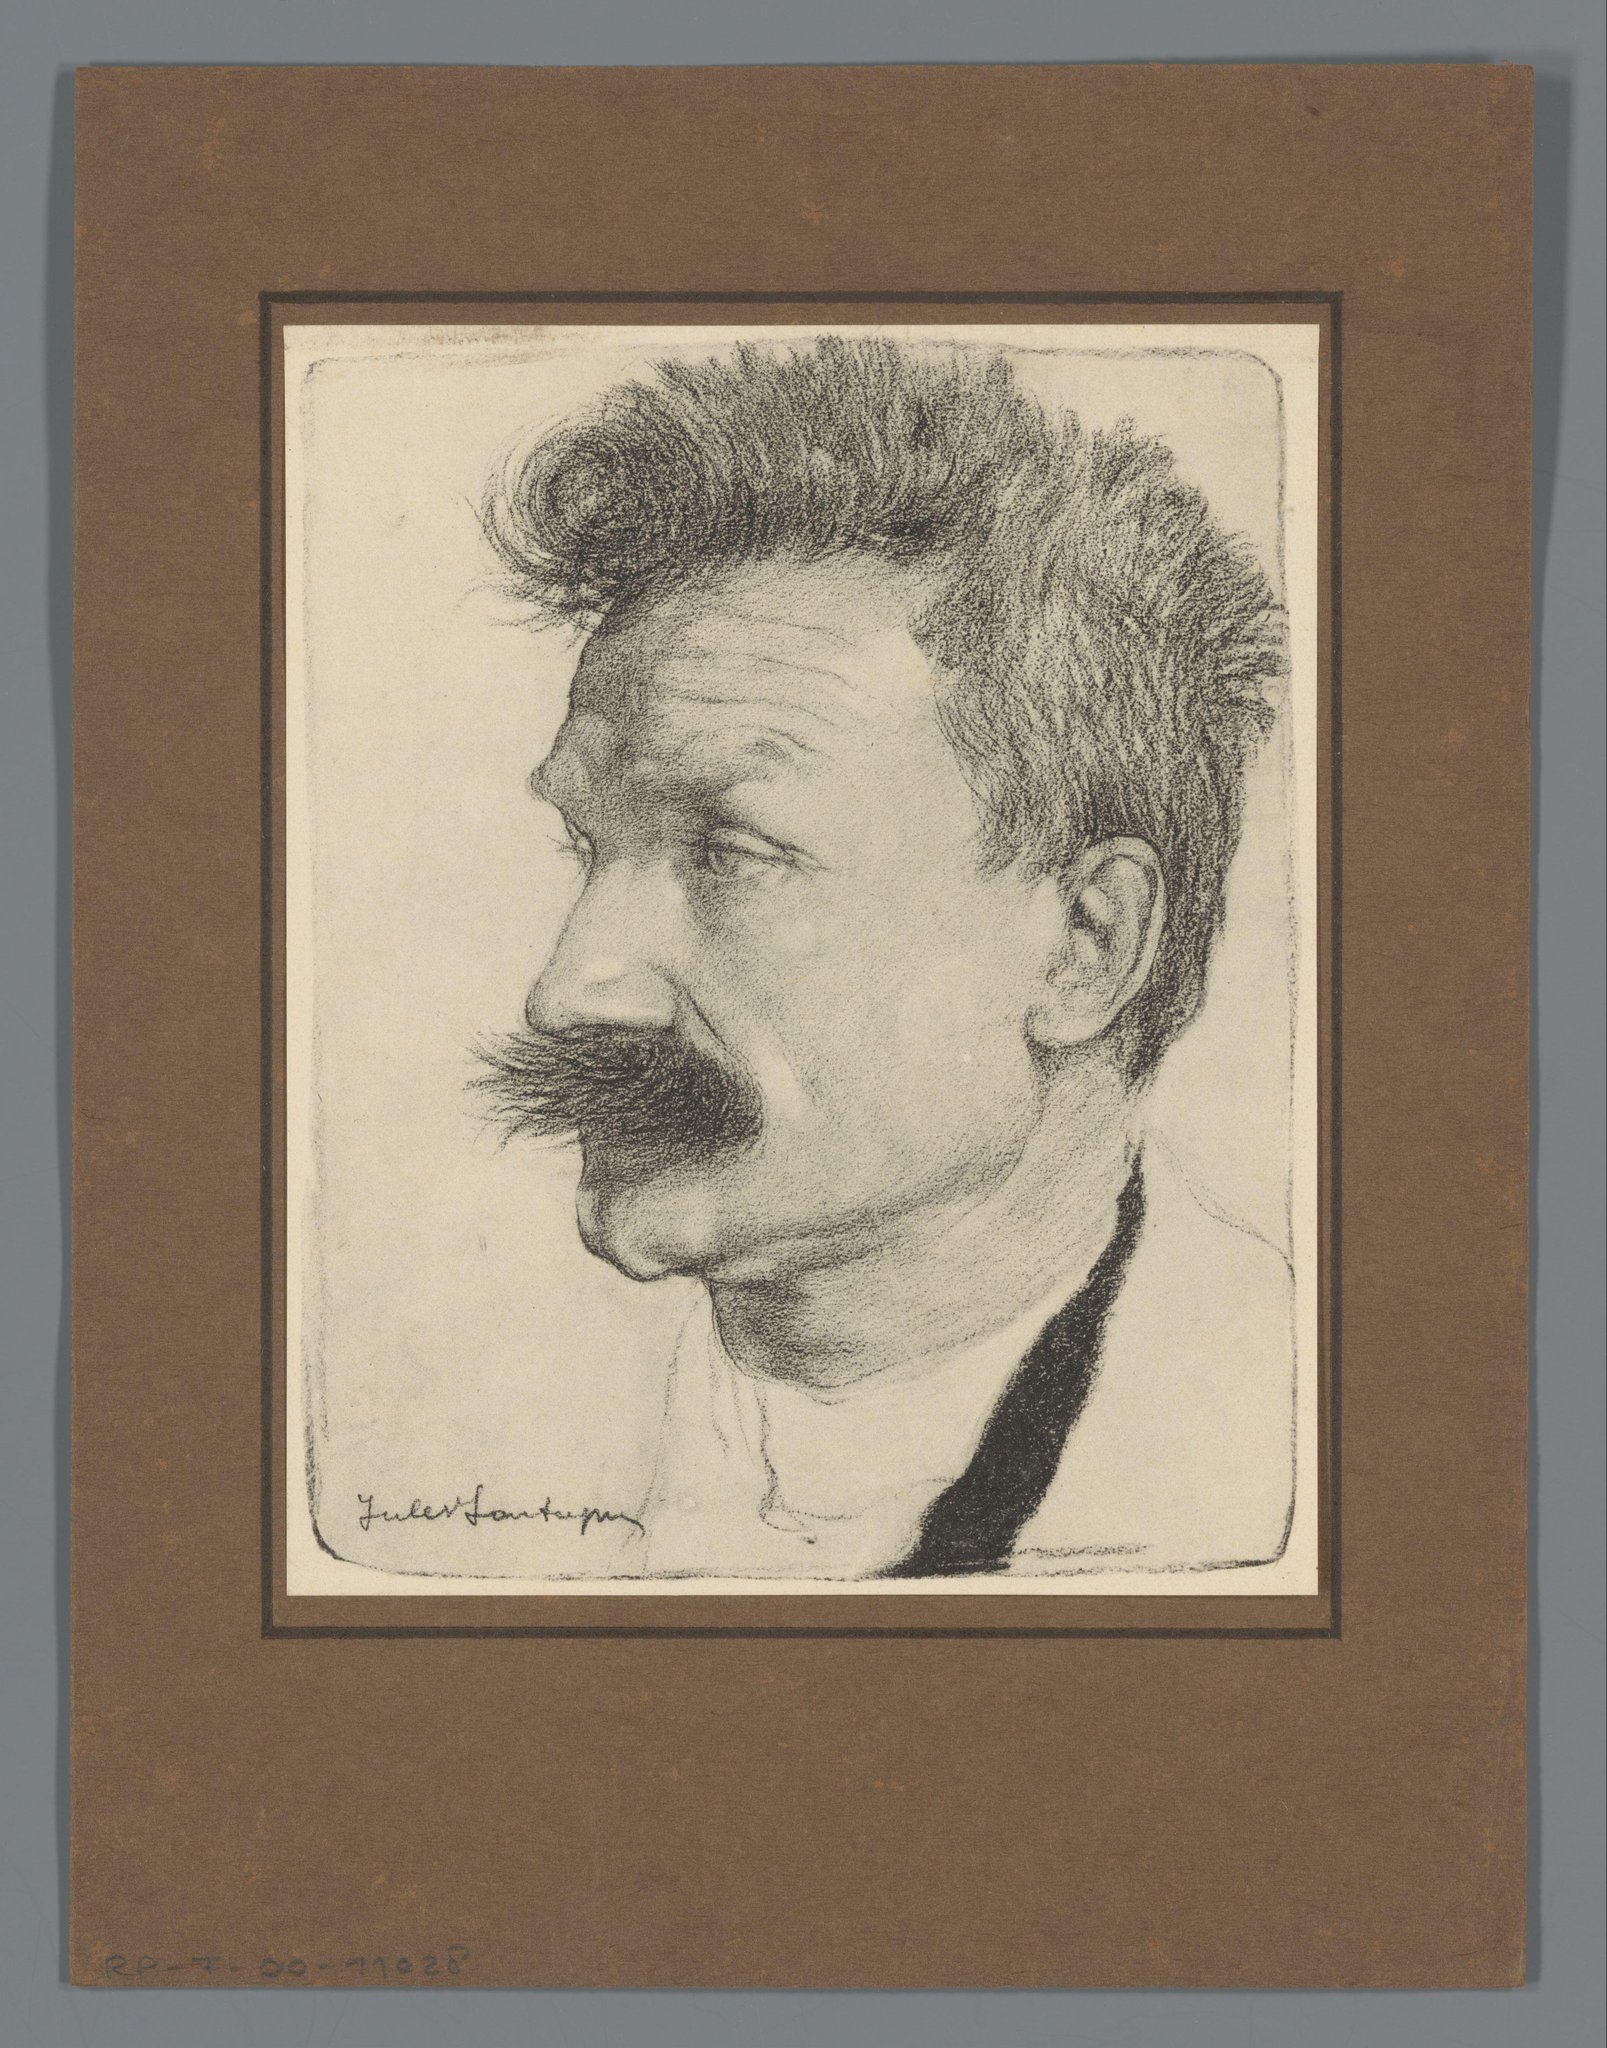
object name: reproduction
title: Reproductie van een getekend portret van Stijn Streuvels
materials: paper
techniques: photograph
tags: stijn streuvels, portrait of a writer